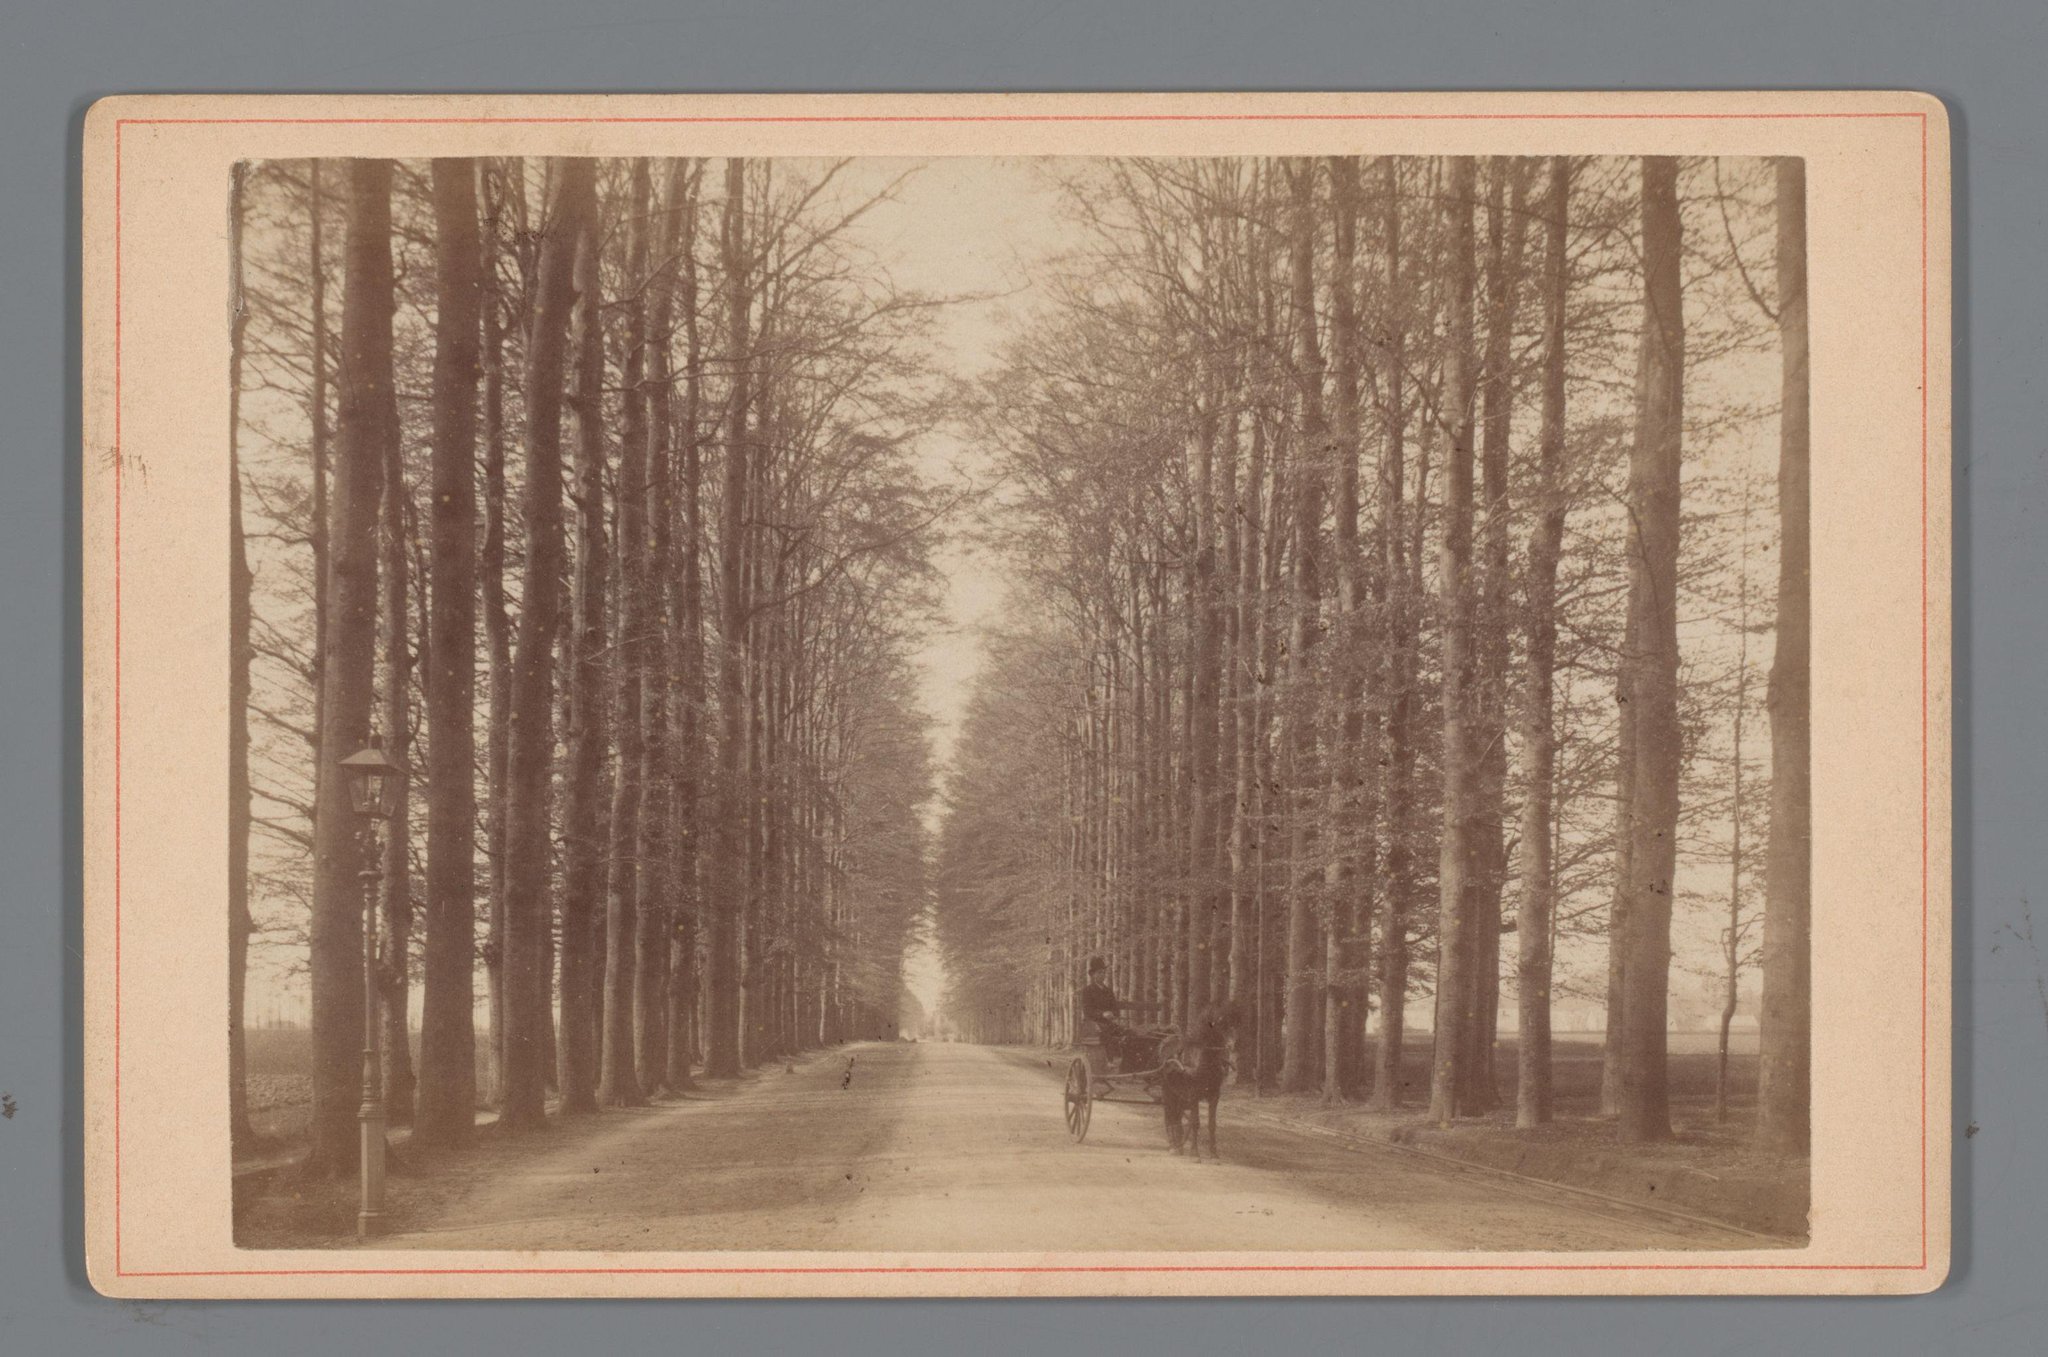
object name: photograph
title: Gezicht op een bomenlaan te Gees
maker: Anonymous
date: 1860-1900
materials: cardboard, photographic support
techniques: albumen print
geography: gees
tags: lane, alley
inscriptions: annotation: ‘Gees/ [Zuiddaeckker Allee?]’